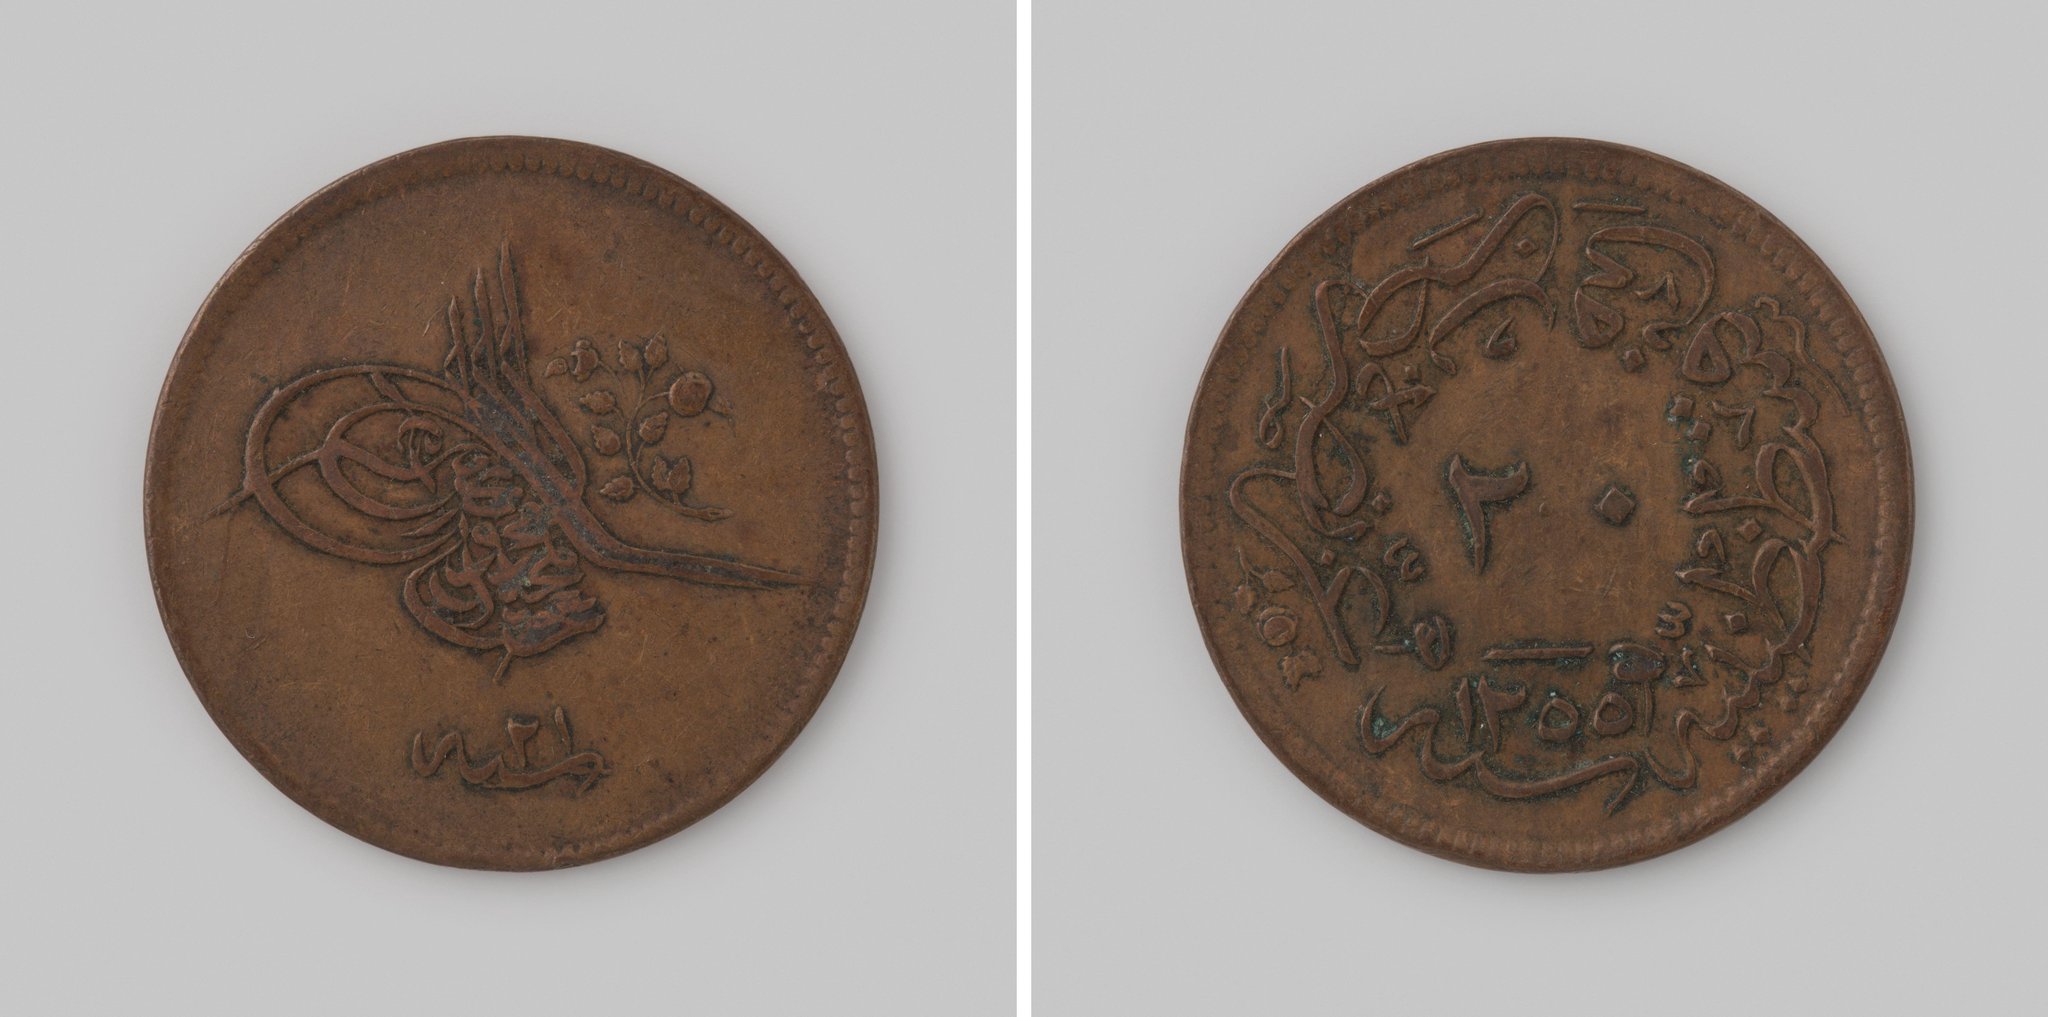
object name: coin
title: 20 para uit Turkije van sultan Abdul Medjid, regeringsjaar 21 [=1859]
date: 1859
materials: copper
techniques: striking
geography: constantinople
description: Koperen munt. Voorzijde: tughra met rechts daarvan takje met bladeren. Daaronder regeringsjaar-aanduiding: 21. Keerzijde: binnen omschrift in Arabische letters waarde-aanduiding: 20. In omschrift muntplaats-aanduiding: Constantinopel en aanduiding jaar van aantreden: 1255 [=1839].